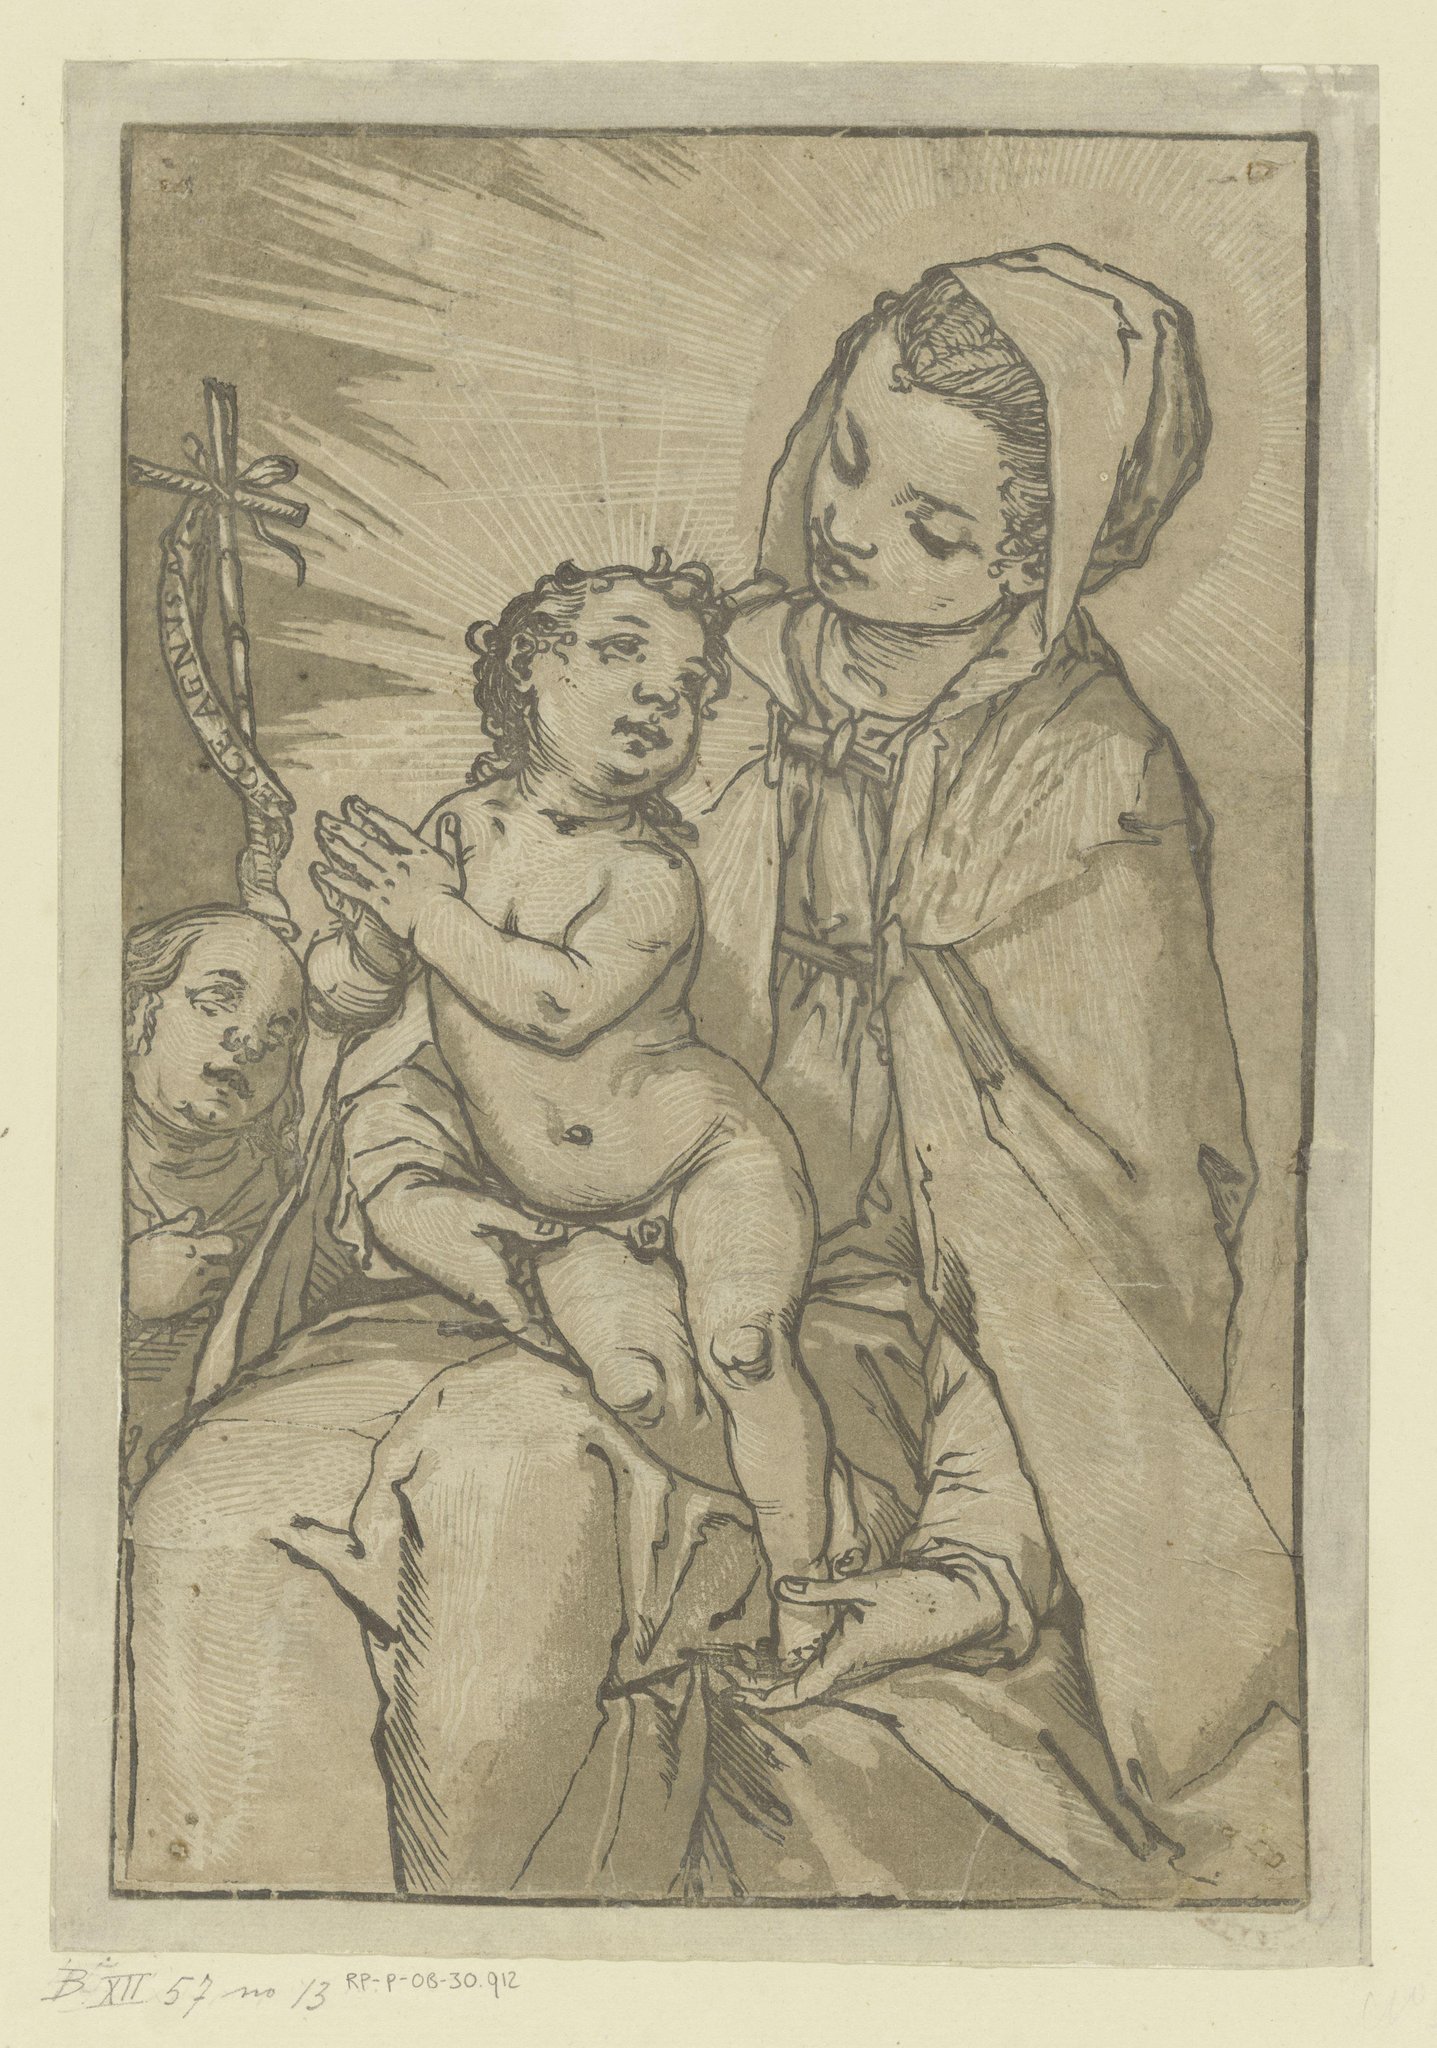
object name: print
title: Maria met Kind en Johannes de Doper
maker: andrea andreani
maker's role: print maker, printer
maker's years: 1558-1629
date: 1591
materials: paper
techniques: woodcut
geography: italy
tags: mary and the christ-child with john the baptist (as child)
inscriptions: collector's mark: Lugt 240